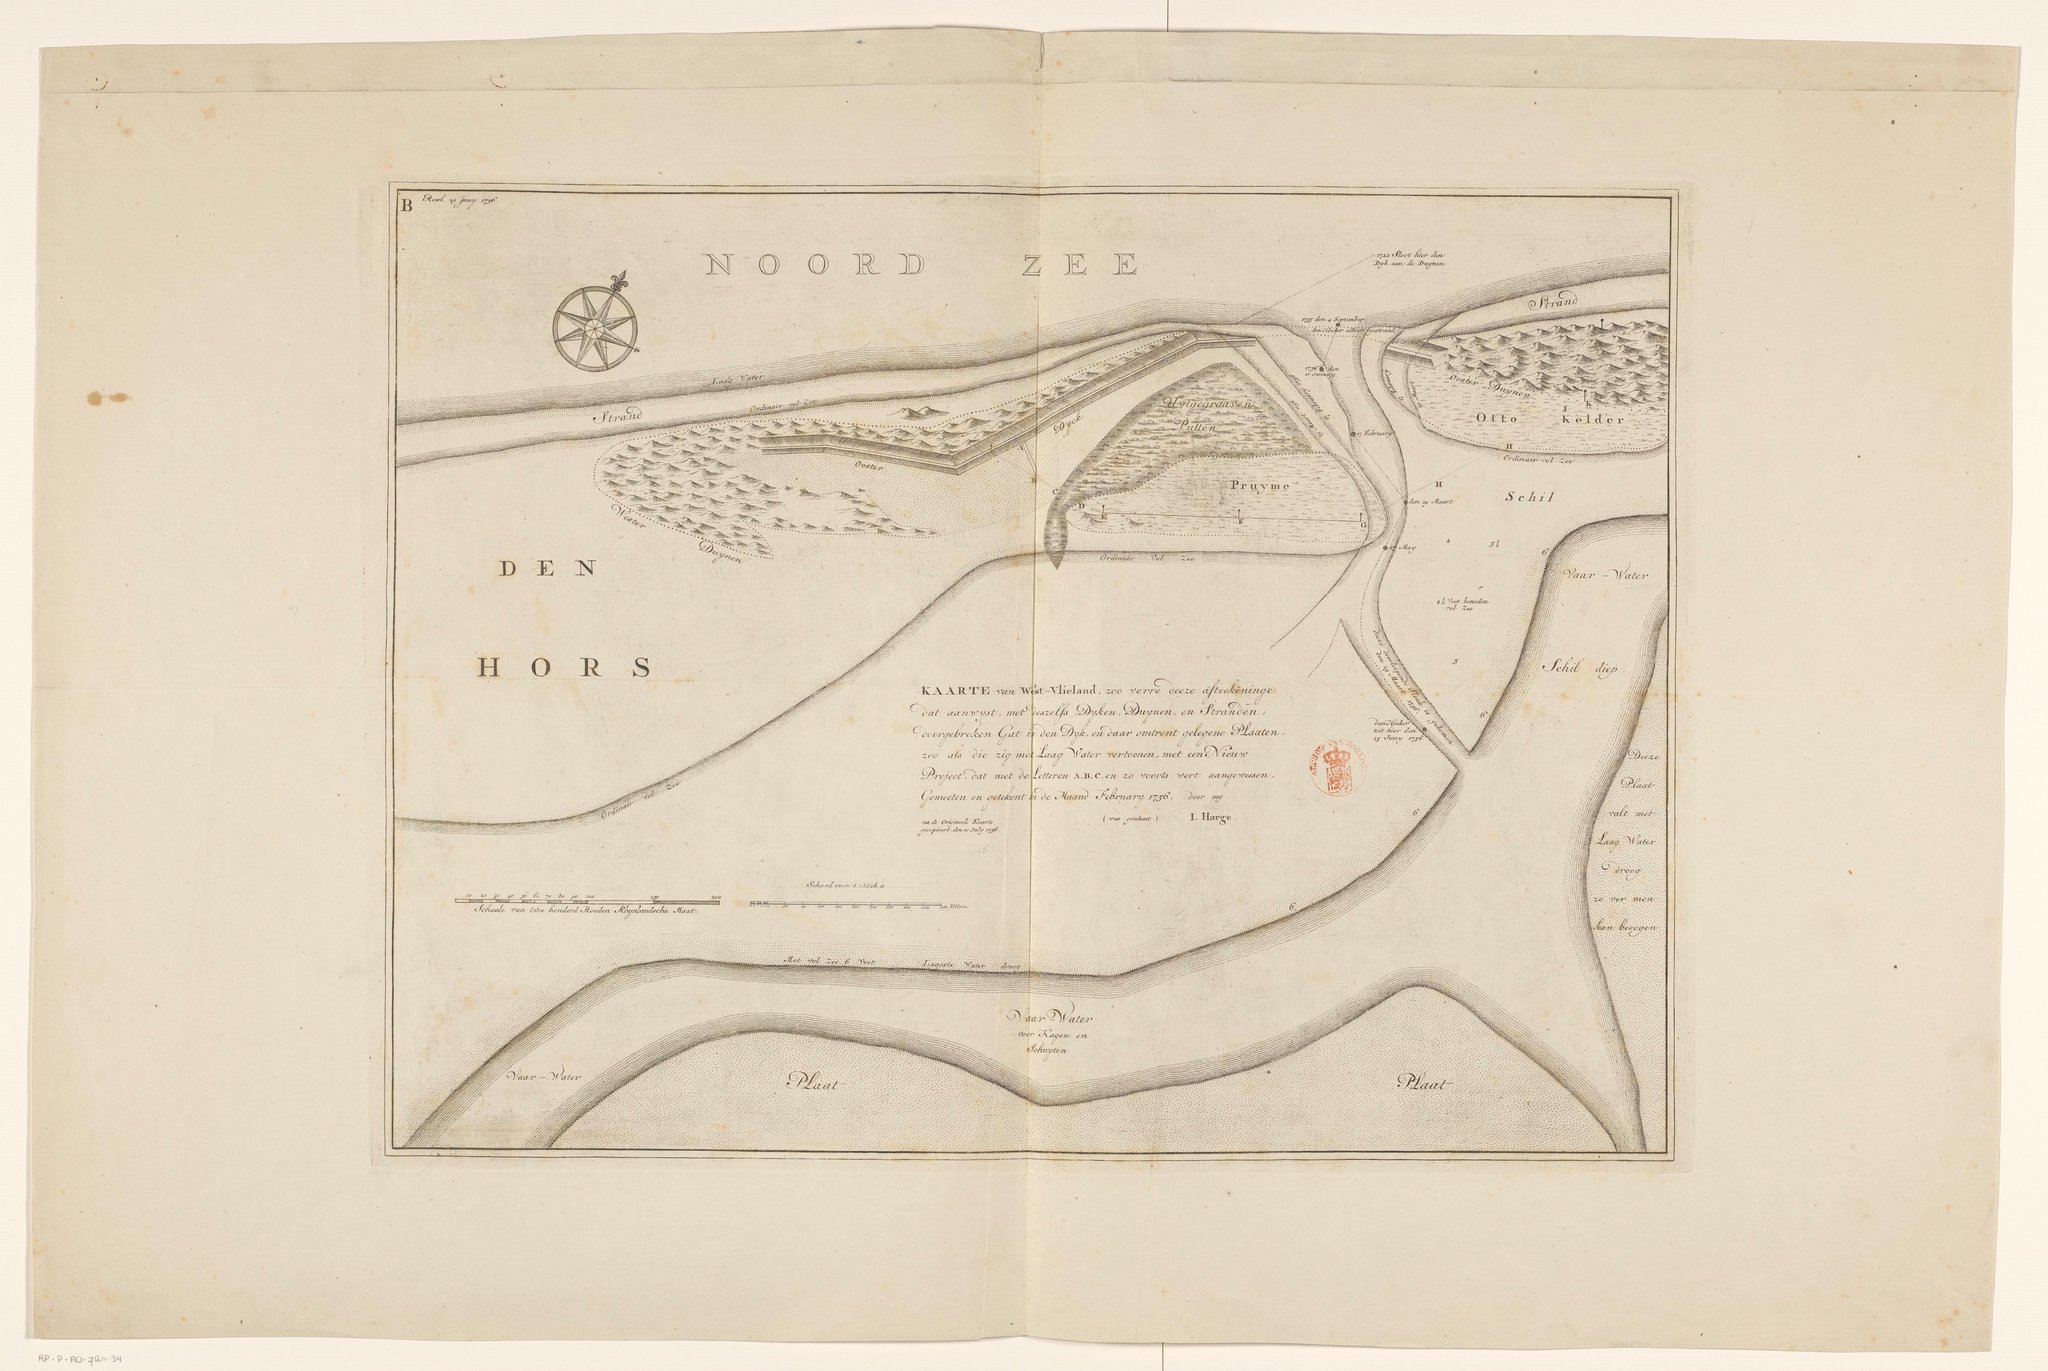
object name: print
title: Kaarte van West-Vlieland, zoo verre deeze afteekeninge dat aanwyst, met dezelfs dyken, duynen, en stranden, doorgebroken gat in den dyk, en daar omtrent gelegene plaaten, zoo als die zig met laag water vertoonen, met een nieuw project, dat met de letteren A.B.C. en zo voorts wert aangewesen …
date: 1756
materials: ink, paper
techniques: engraving, etching, pen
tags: maps of separate countries or regions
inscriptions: inscription, collector's mark: Lugt 19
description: Rechts een schaalstok: Schaale van twee honderd roeden Rhynlandsche maat. In het midden de titel.